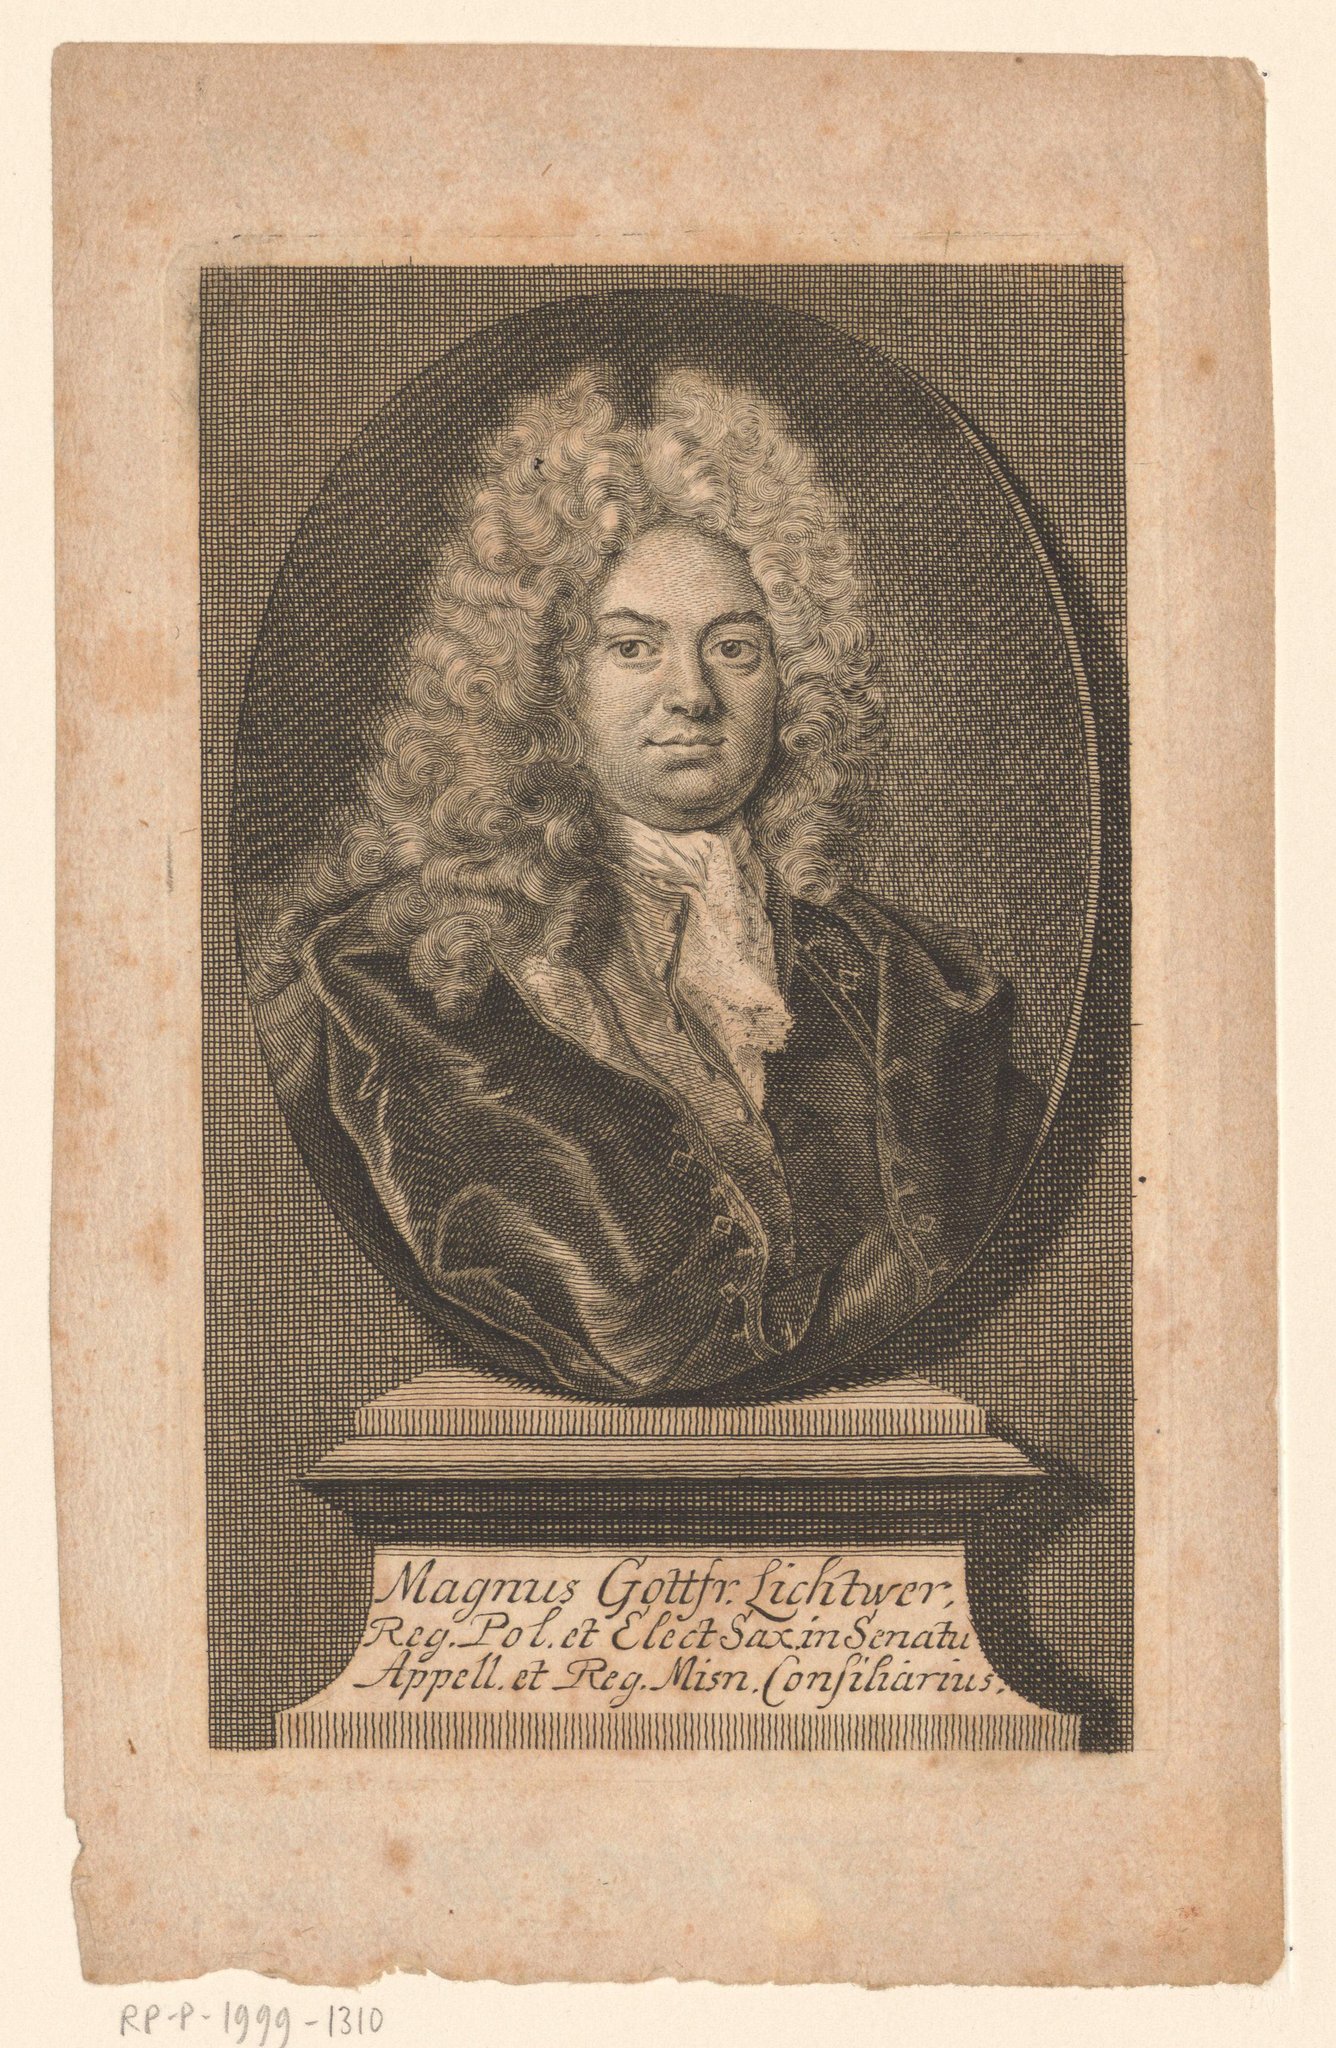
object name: print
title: Portret van Magnus Gottfried Lichtwer (I)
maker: martin bernigeroth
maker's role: print maker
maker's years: 1670-1733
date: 1719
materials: paper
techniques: engraving, etching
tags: ornament ~ medallion, historical persons, wig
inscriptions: collector's mark: Lugt 2760, collector's mark: Lugt 2228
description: Prent waarschijnlijk uit: Deutsche Acta Eruditorum (...). Leipzig: Johann Gottlieb Gleditsch, 1719, dl. 62.